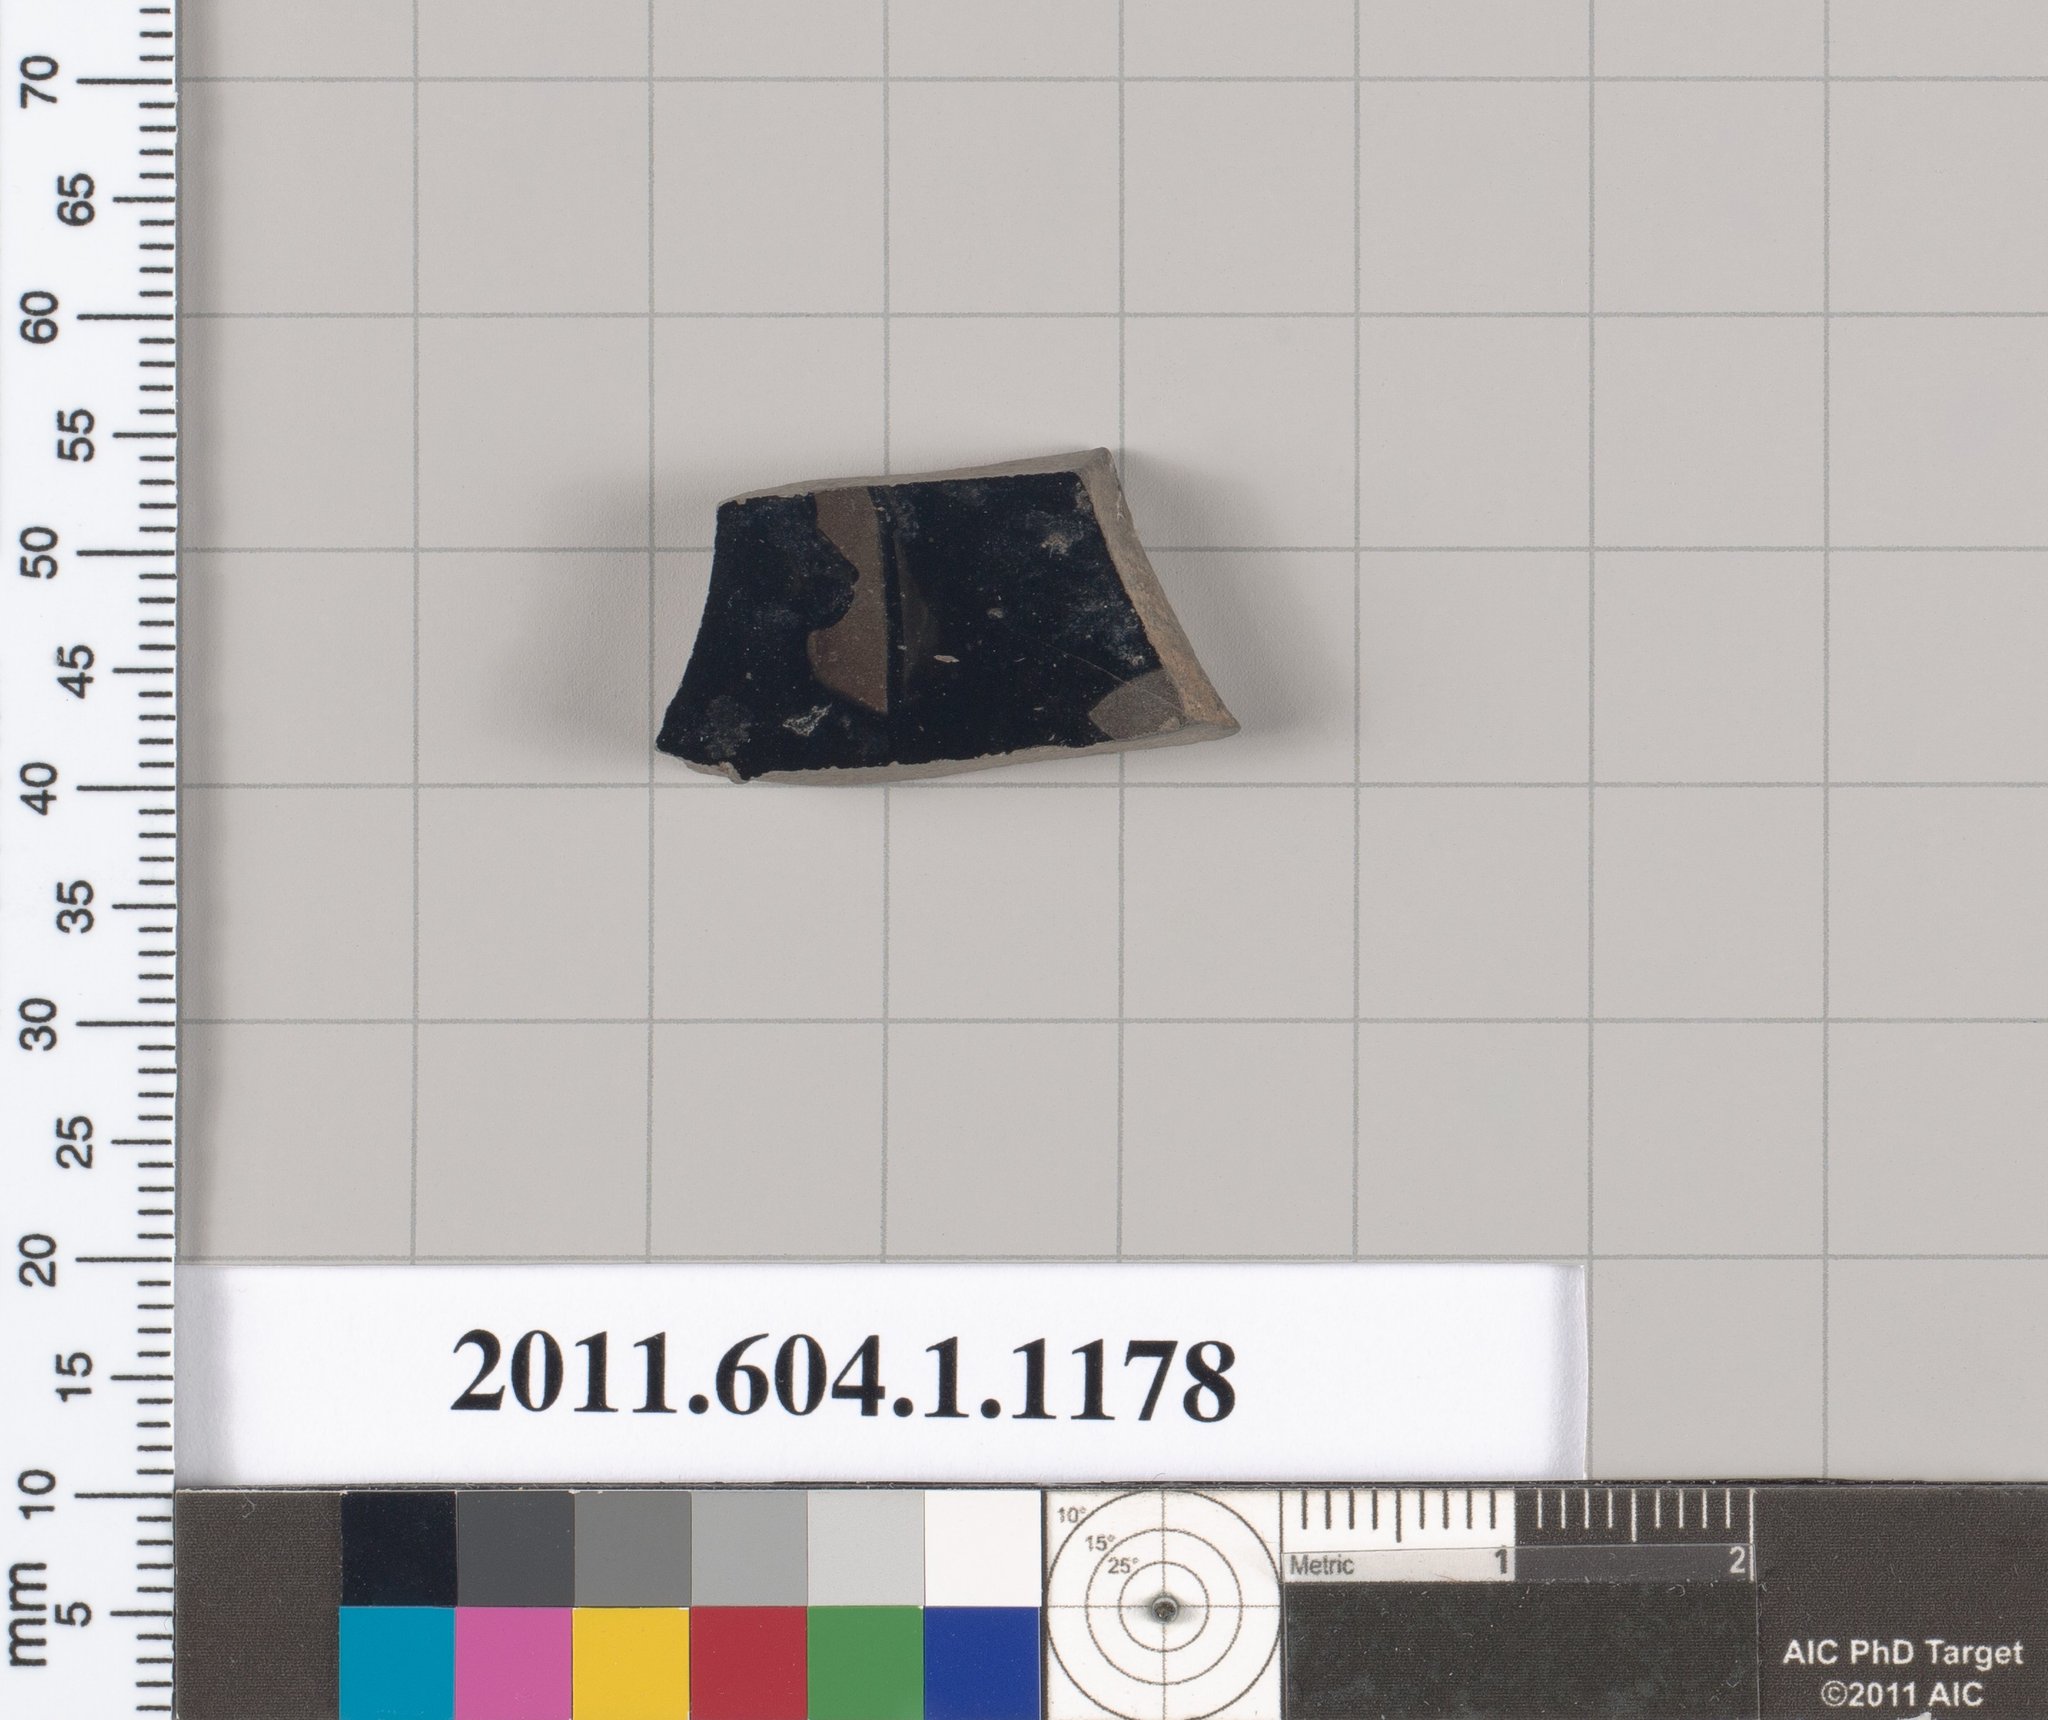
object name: kylix fragment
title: Terracotta fragment of a kylix (drinking cup)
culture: greek, attic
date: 490-480 BCE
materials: terracotta